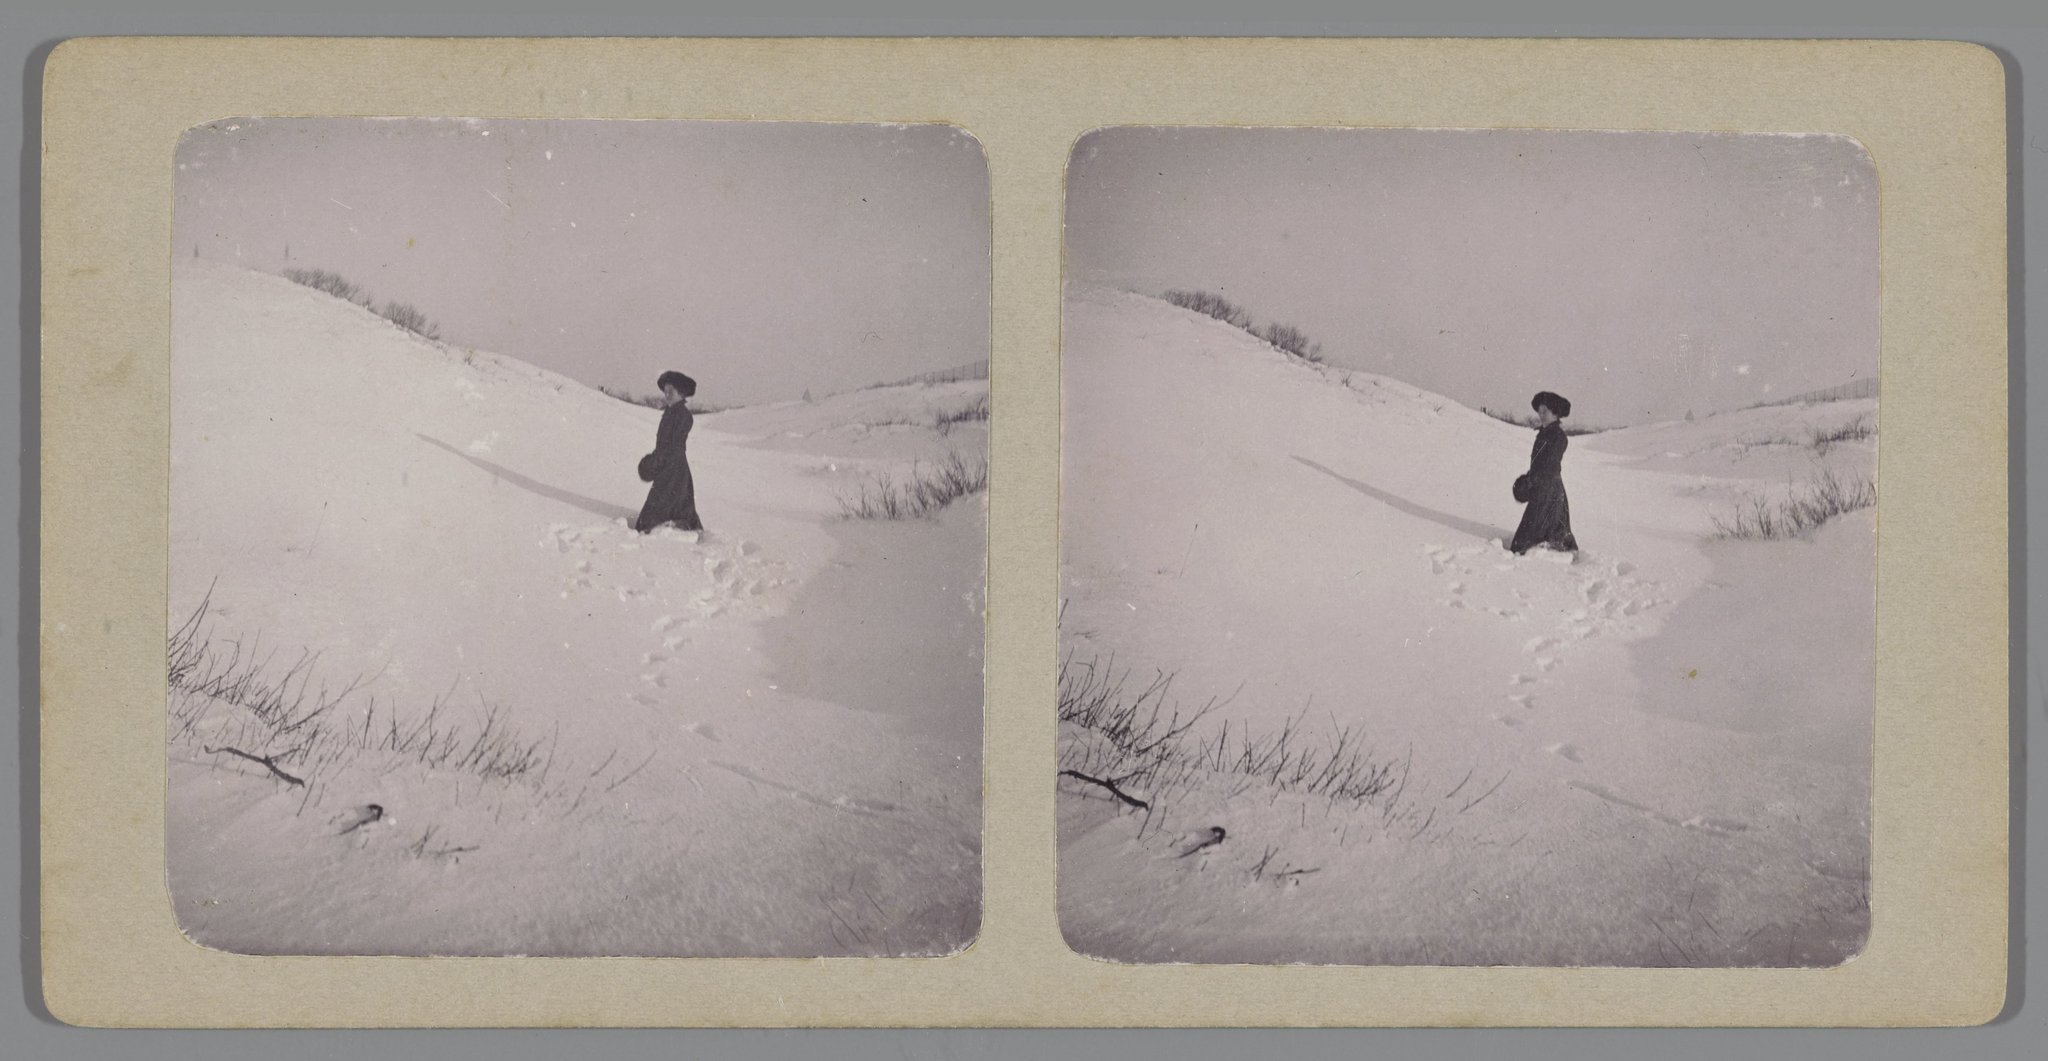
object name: stereograph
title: Stereoscopic Photographs of Kraantje Lek in the Snow, the Stairs to the Beach at Wijk aan Zee, and Fun on the Ice on the Wetering in Amsterdam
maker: Anonymous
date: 1890-1920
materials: paper, cardboard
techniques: collodion silver print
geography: kraantje lek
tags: dunes (sea not visible); in the dunes, snow